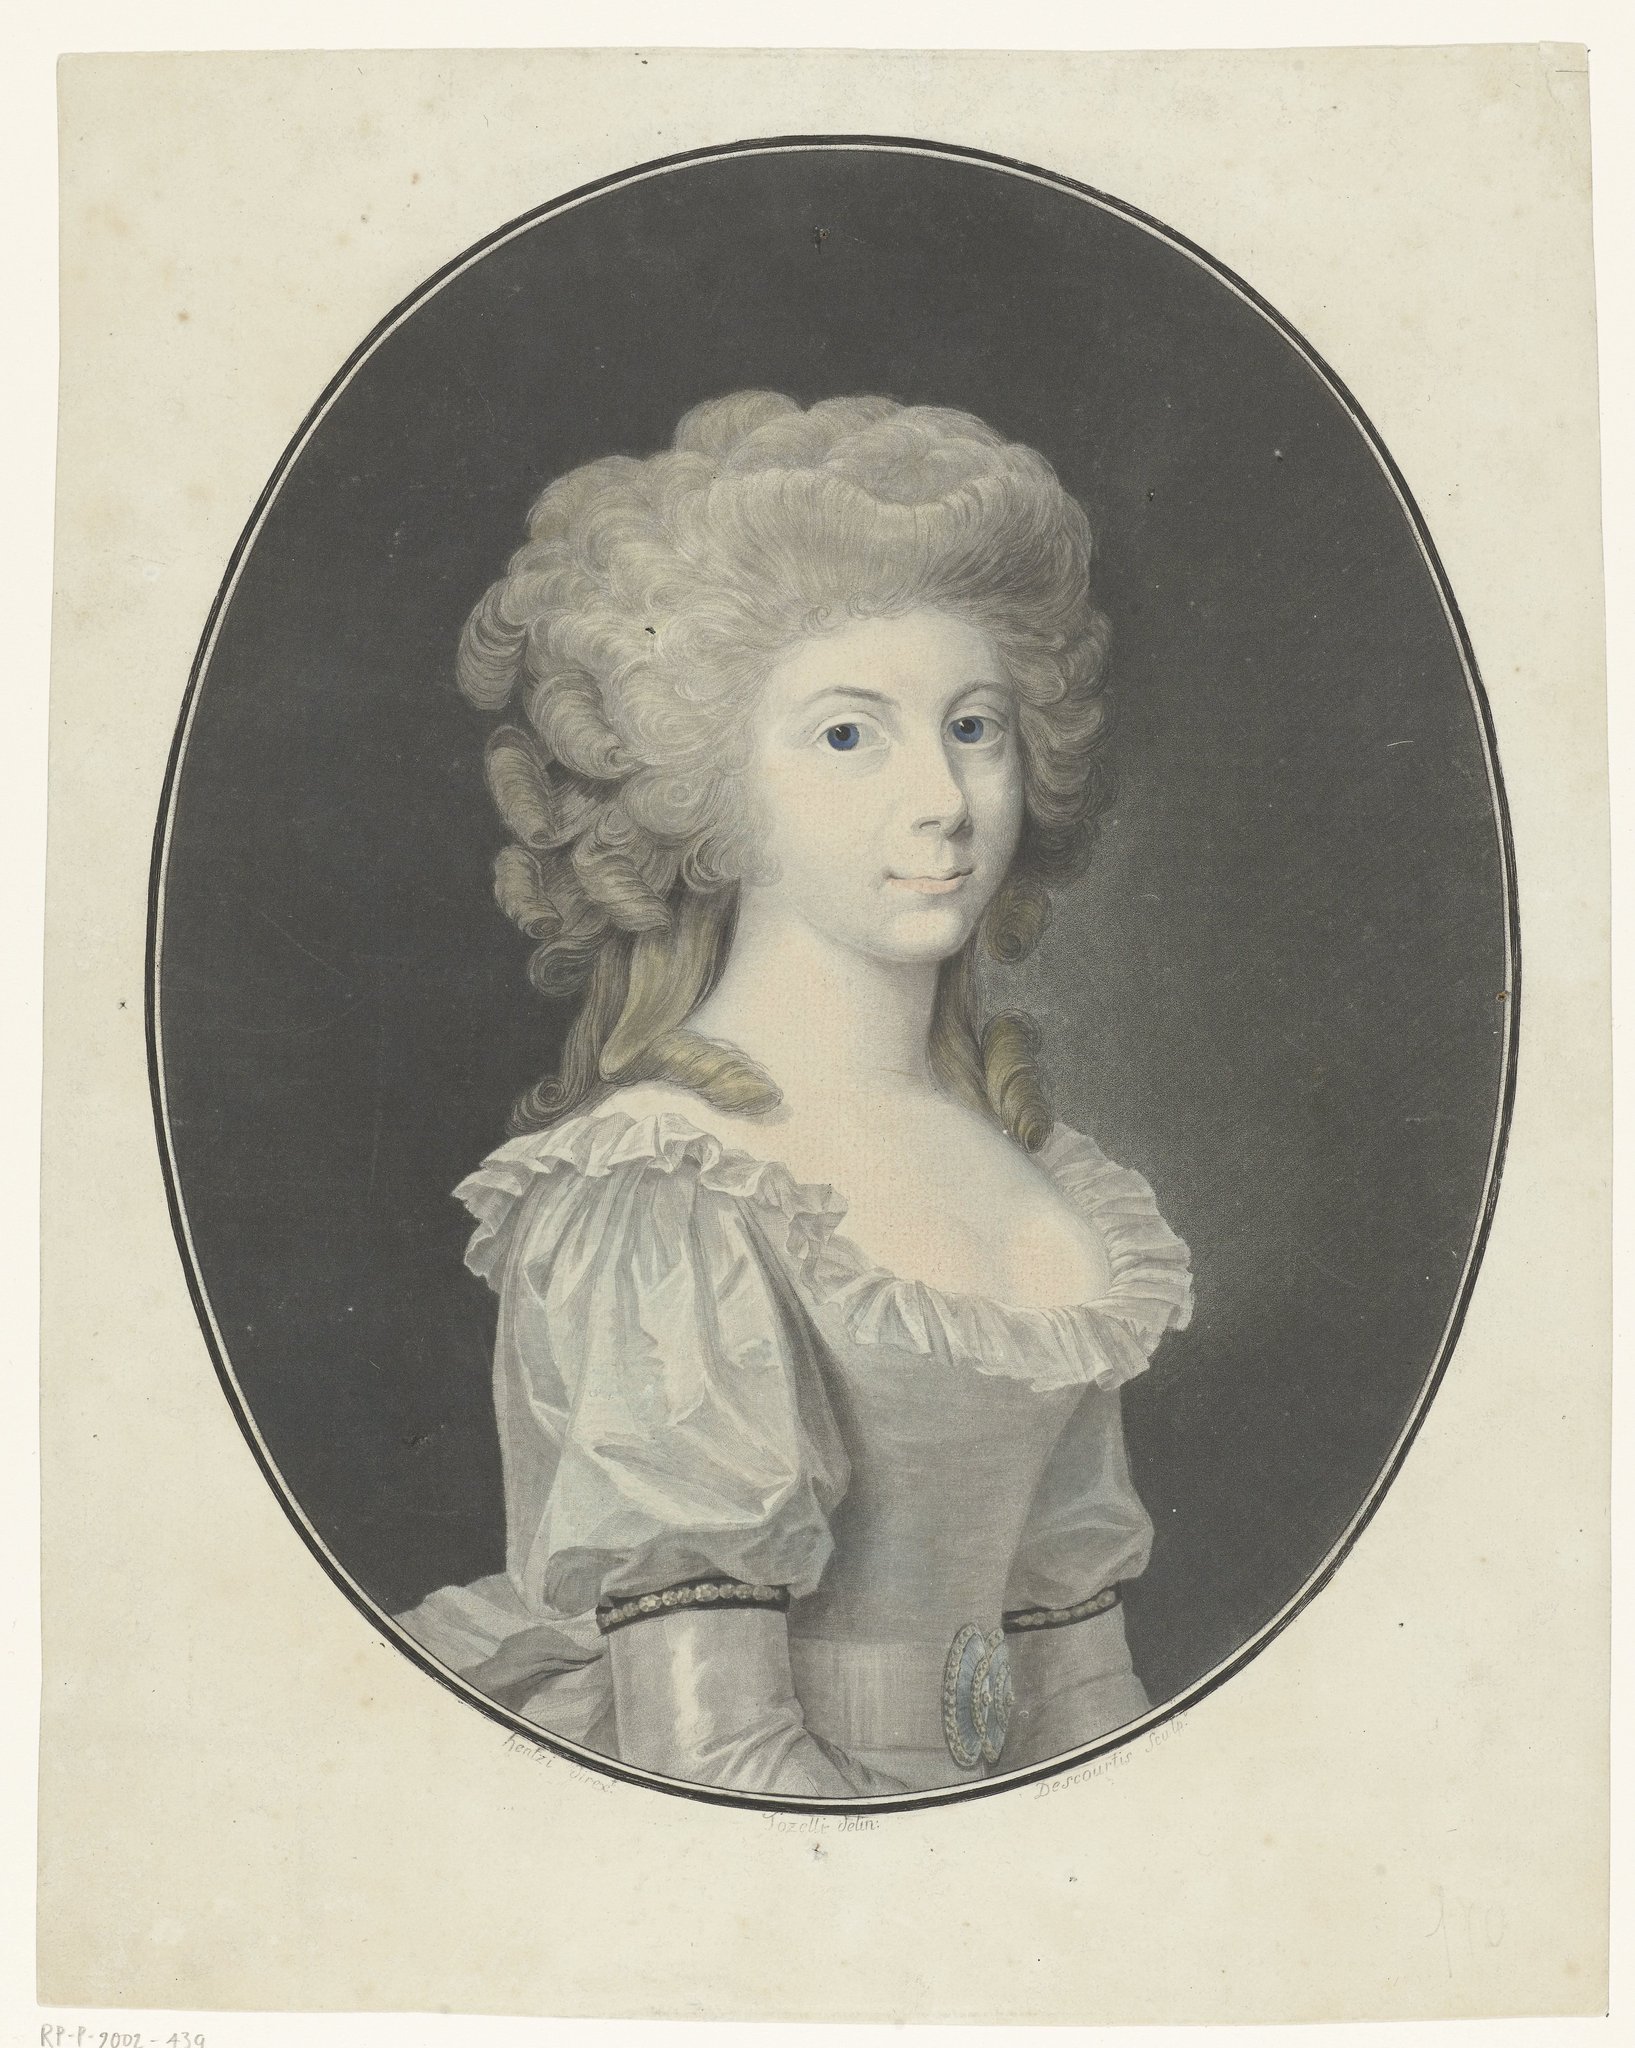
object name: print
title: Portret van Frederica Louise Wilhelmina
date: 1780-1803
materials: chalk, paper, watercolor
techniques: brush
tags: louise (prinses van oranje-nassau)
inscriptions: collector's mark: Lugt 2760, collector's mark: Lugt 2228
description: Portret van Frederica Louise Wilhelmina van Pruisen, prinses van Oranje-Nassau. Buste naar rechts, in ovaal.